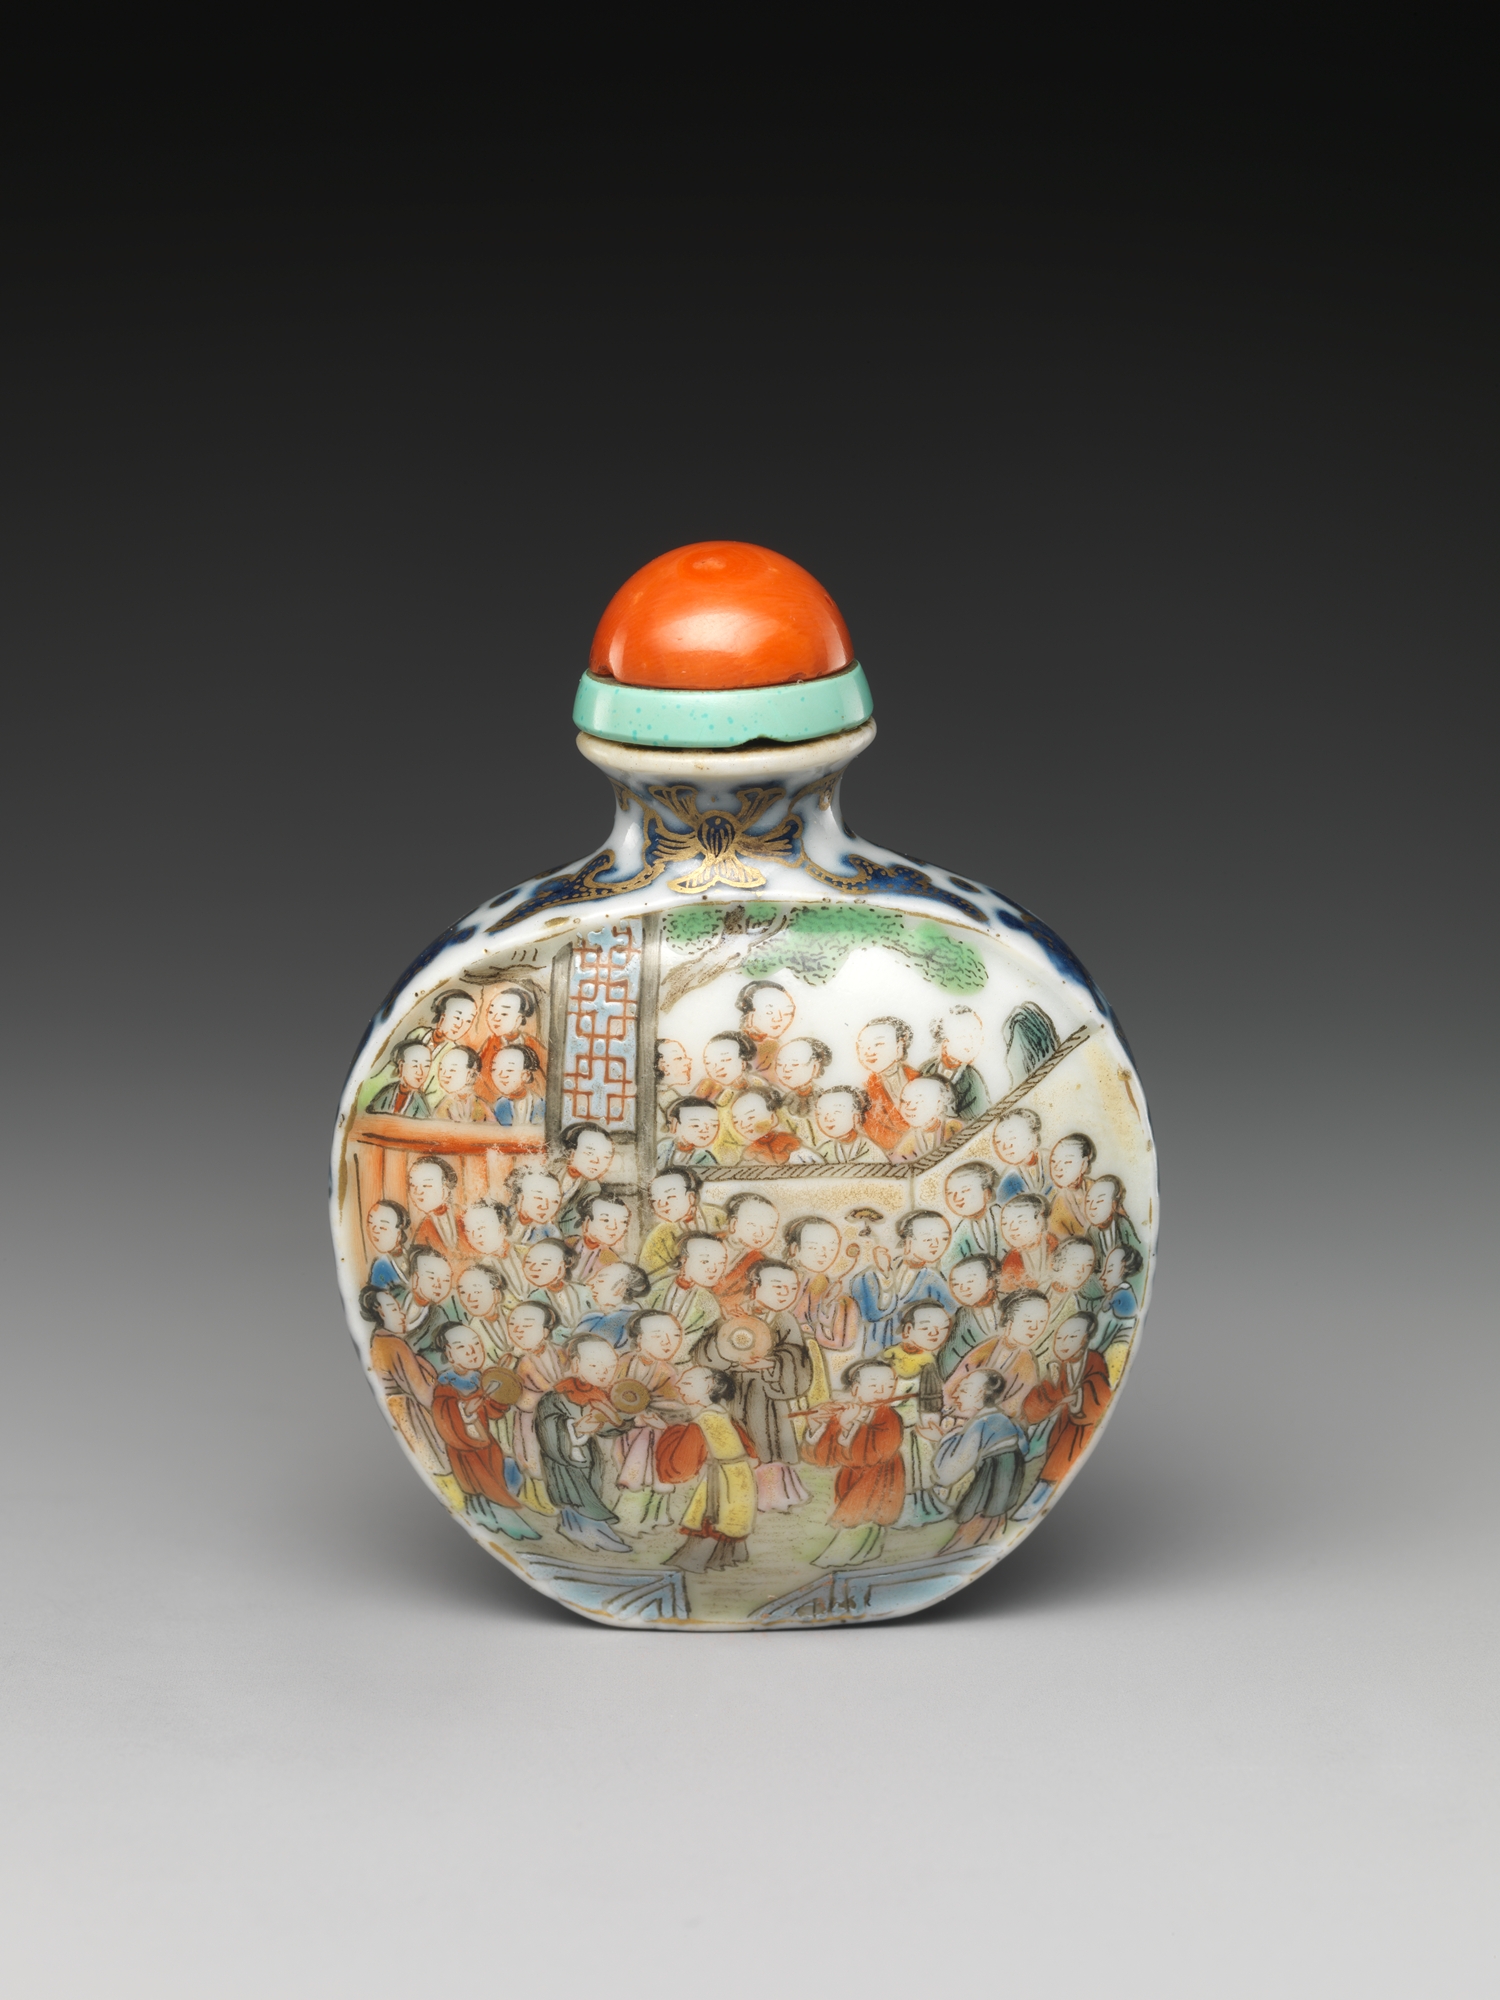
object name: snuff bottle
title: Snuff Bottle with Hundred Beauties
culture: chinese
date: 1701-1800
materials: coral, enamel, porcelain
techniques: overglaze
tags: human figures,musical instruments